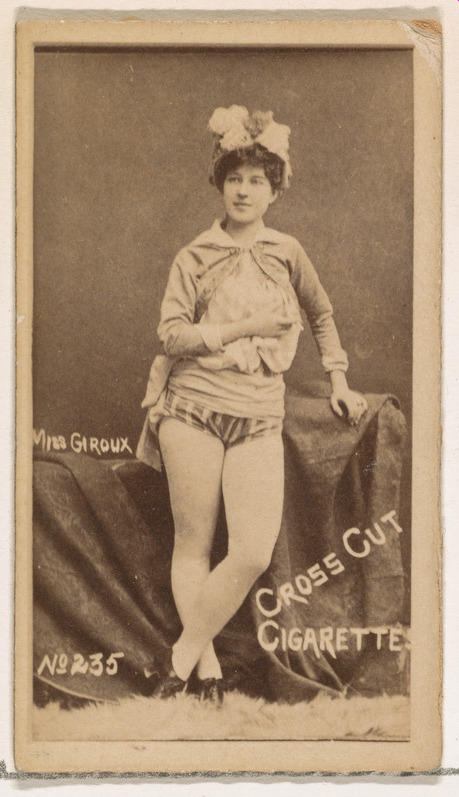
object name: print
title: Card Number 235, Miss Giroux, from the Actors and Actresses series (N145-1) issued by Duke Sons & Co. to promote Cross Cut Cigarettes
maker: w. duke, sons & co.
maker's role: publisher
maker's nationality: american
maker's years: 1870-1920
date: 1880-1889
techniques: albumen silver print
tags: portraits,women,actresses